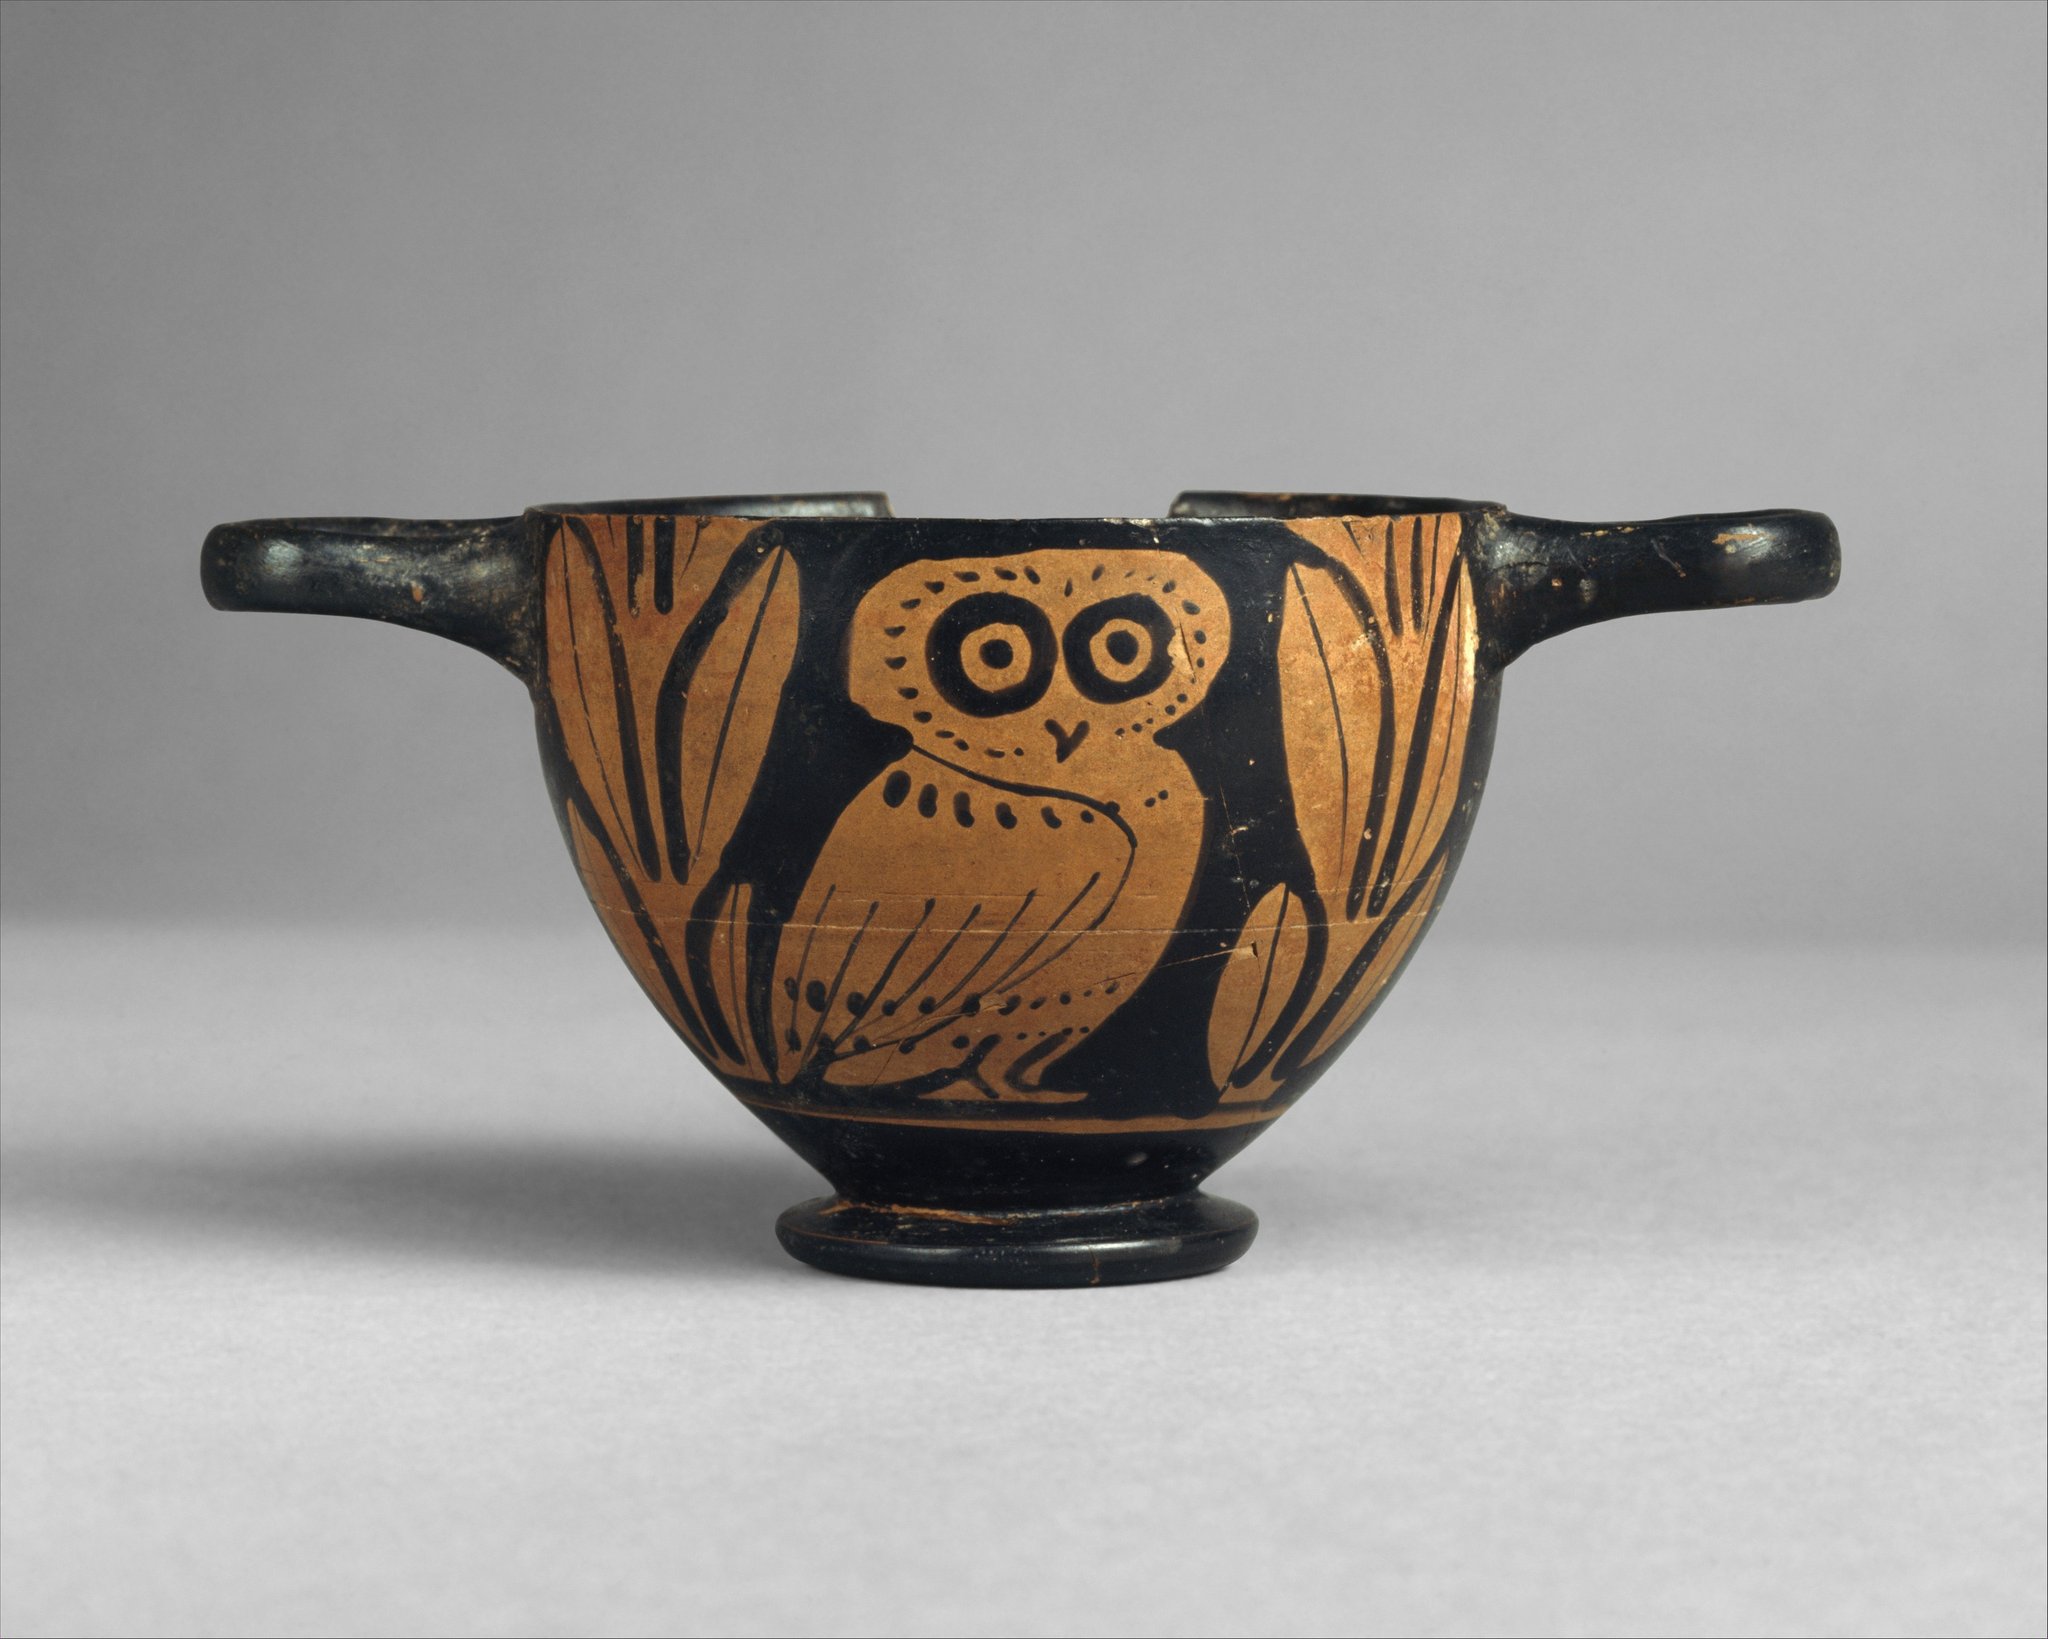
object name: skyphos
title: Terracotta skyphos (deep drinking cup)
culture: greek, attic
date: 467-435 BCE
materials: terracotta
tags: owls